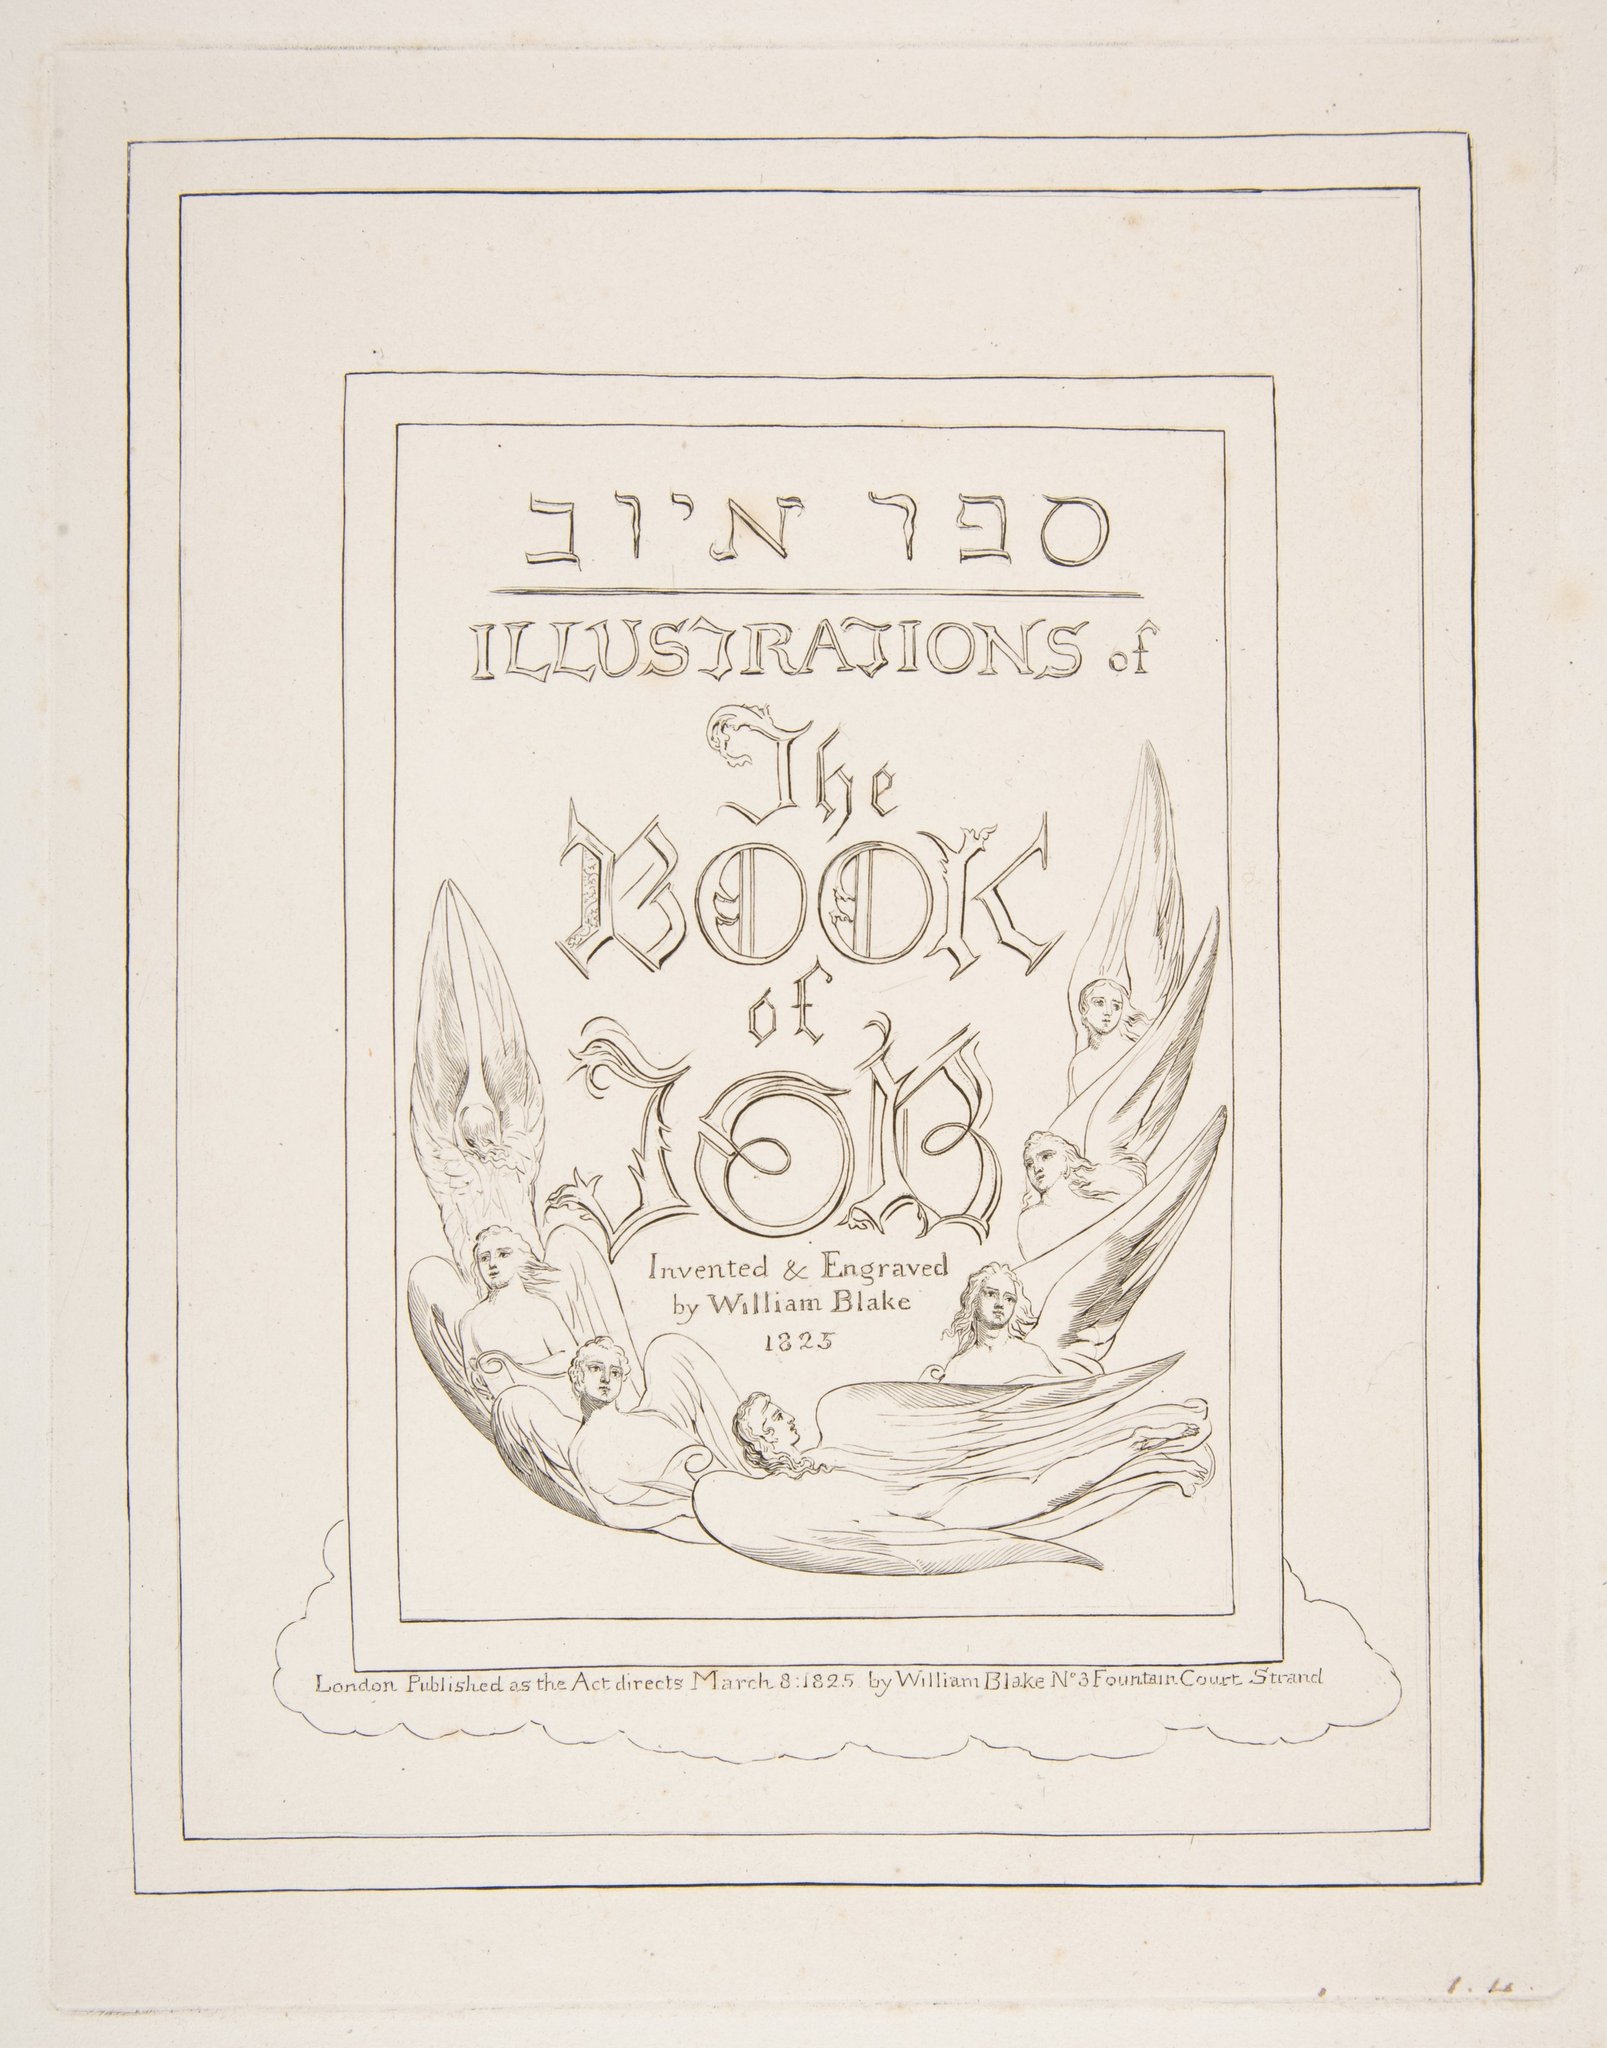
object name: print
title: Title Page: Illustrations of the Book of Job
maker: william blake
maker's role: artist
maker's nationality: british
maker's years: 1757-1827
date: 1825-1826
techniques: engraving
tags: angels,job